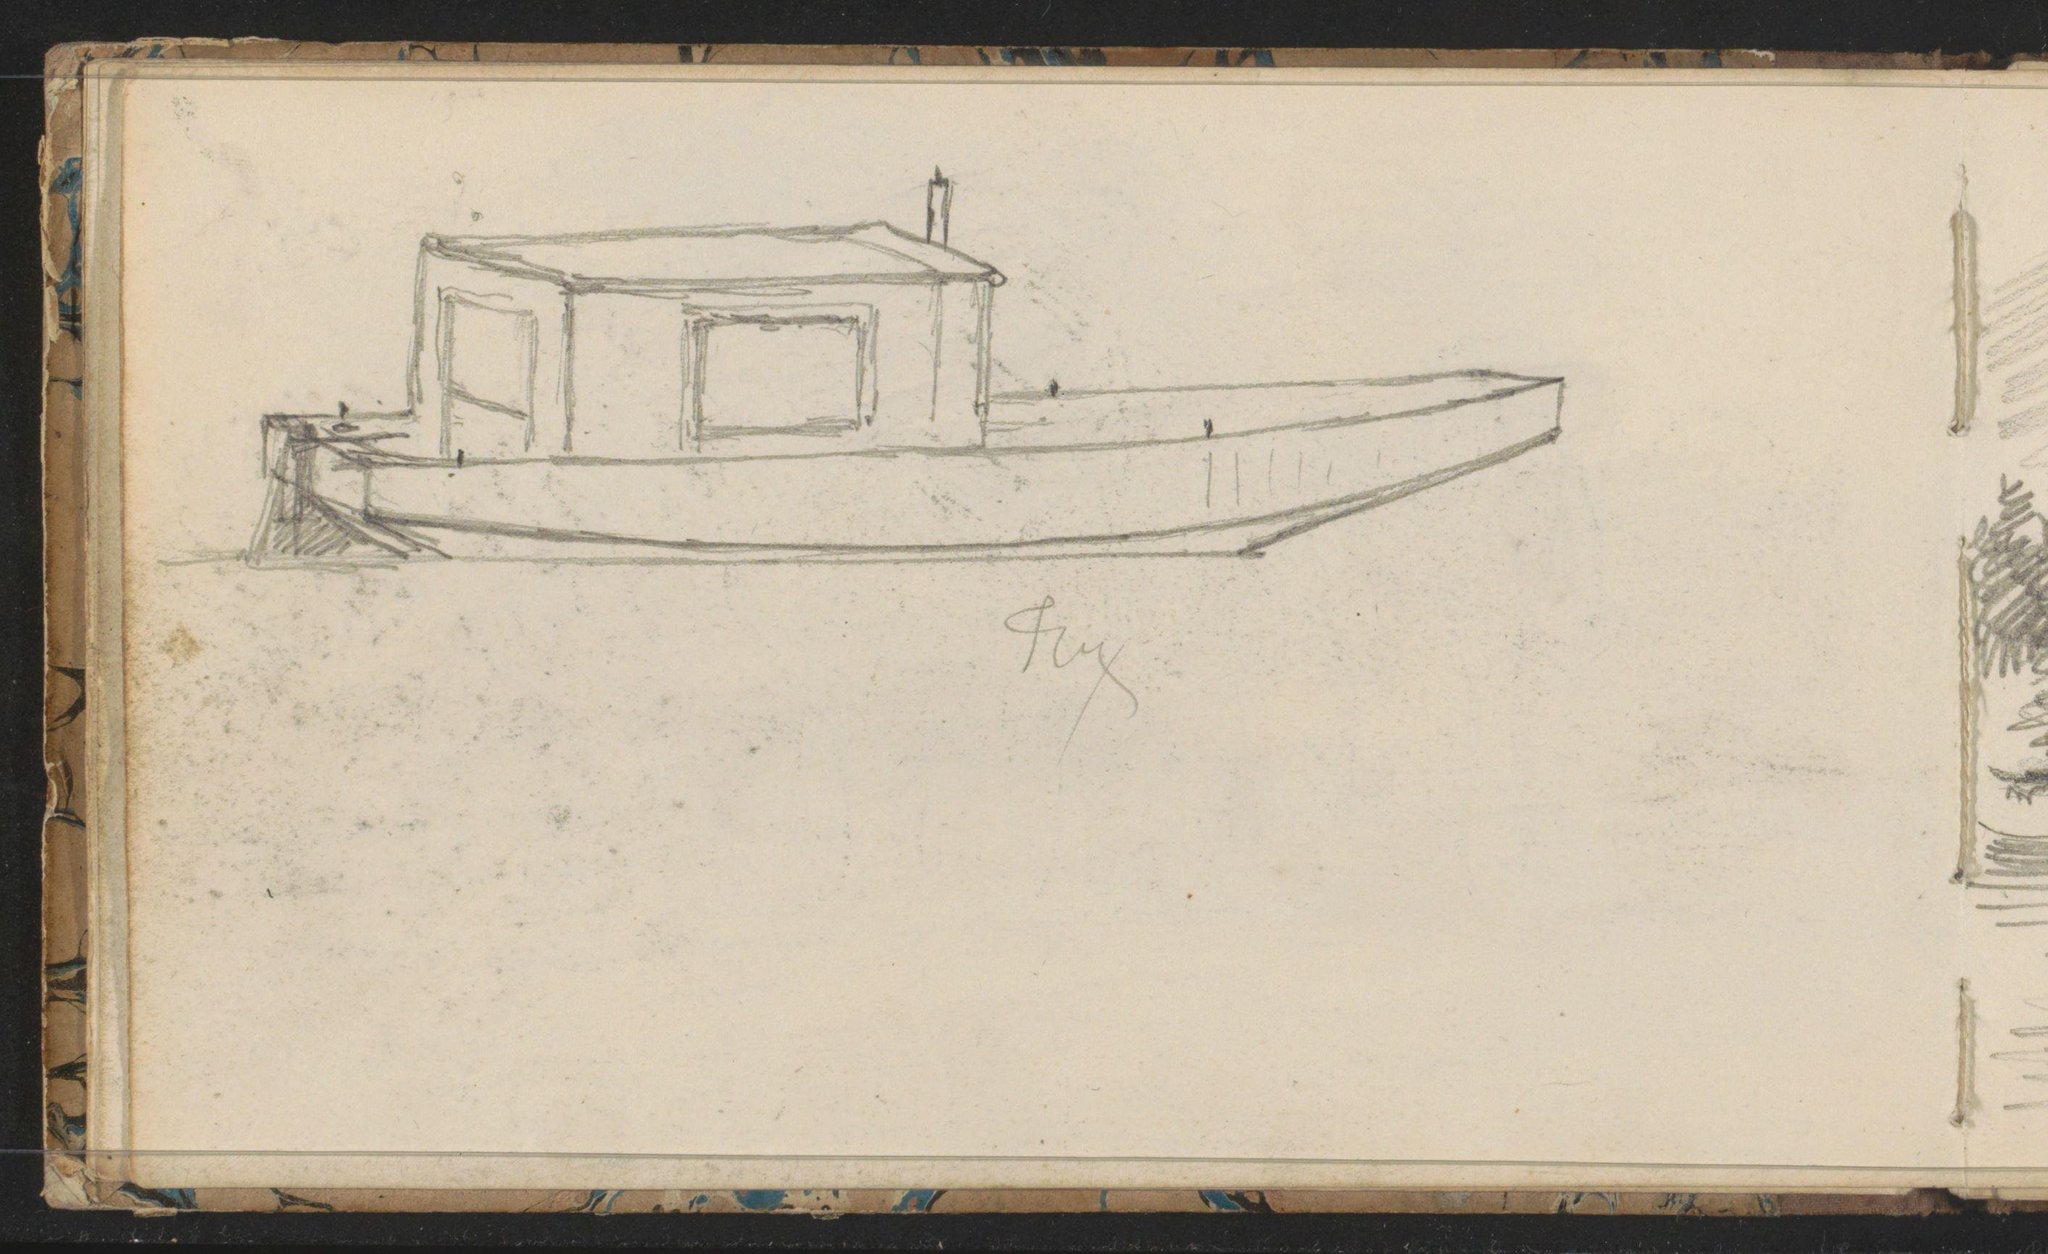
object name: sketchbook leaf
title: Boot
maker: arnoldus johannes eymer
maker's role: draughtsman, print maker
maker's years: 1803-1863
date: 1803-1818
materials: paper, pencil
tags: boat propelled by man or animal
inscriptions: annotation: ‘Ny?’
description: Bladzijde 8 uit een schetsboek met 74 bladzijden.